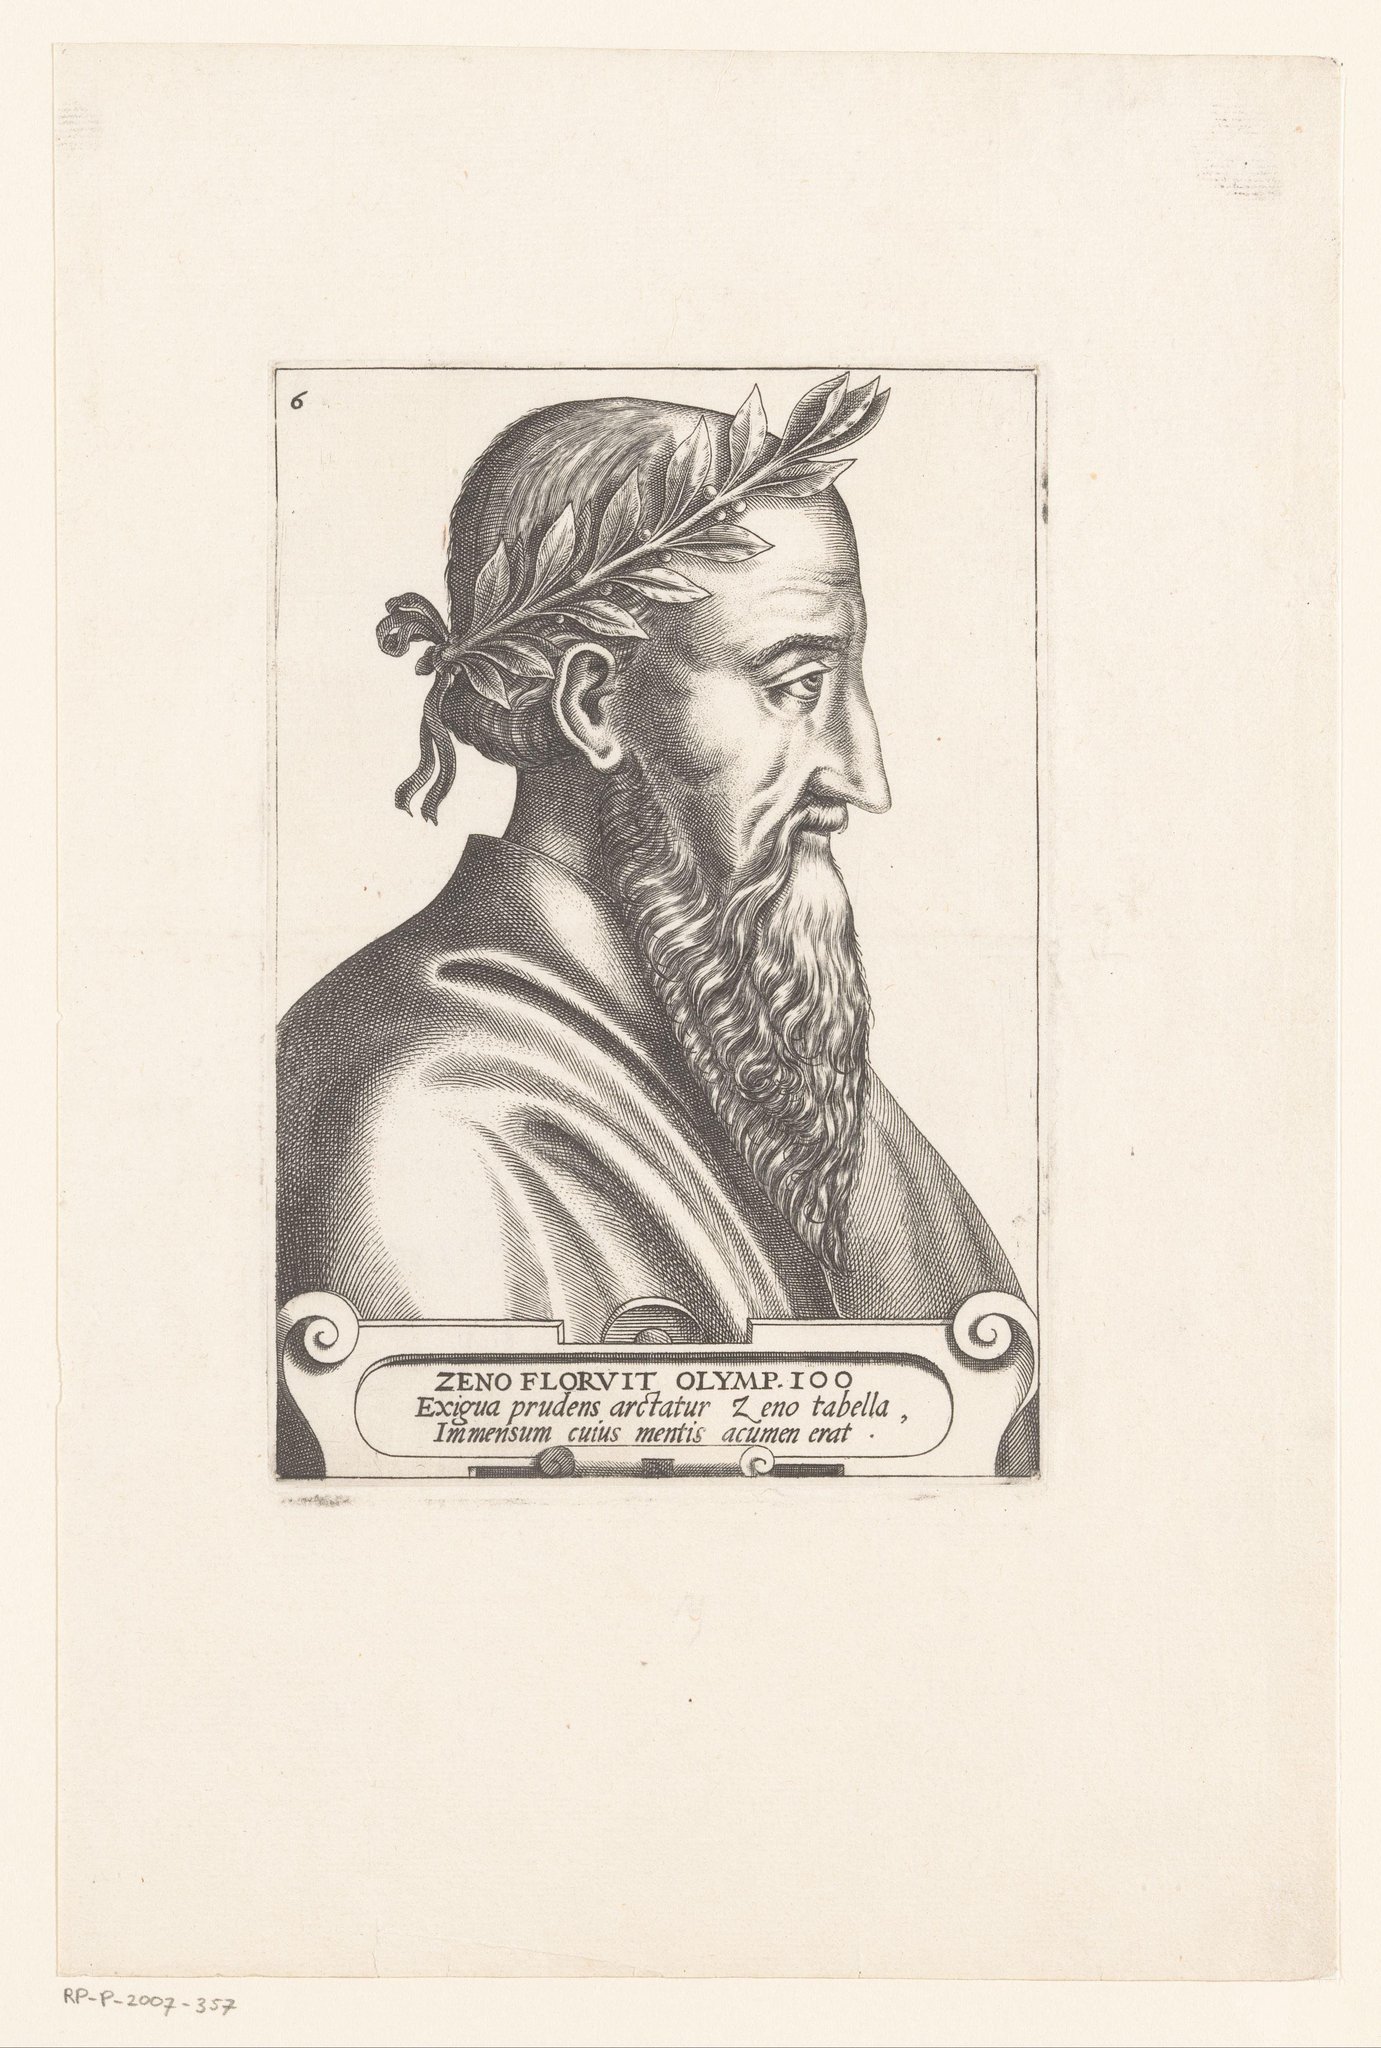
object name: print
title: Portretten van Griekse en Romeinse filosofen en schrijvers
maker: rené boyvin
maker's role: print maker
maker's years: 1525-1598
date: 1566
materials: paper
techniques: engraving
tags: scholar, philosopher, historical persons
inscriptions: collector's mark: Lugt 2760, collector's mark: Lugt 2228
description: Maakt deel uit van een serie van twaalf portretten van Griekse en Romeinse filosofen, getiteld 'Illustrium philosophorum et poetarum effigies', uitgegeven in 1566 door P. de Roville in Parijs.